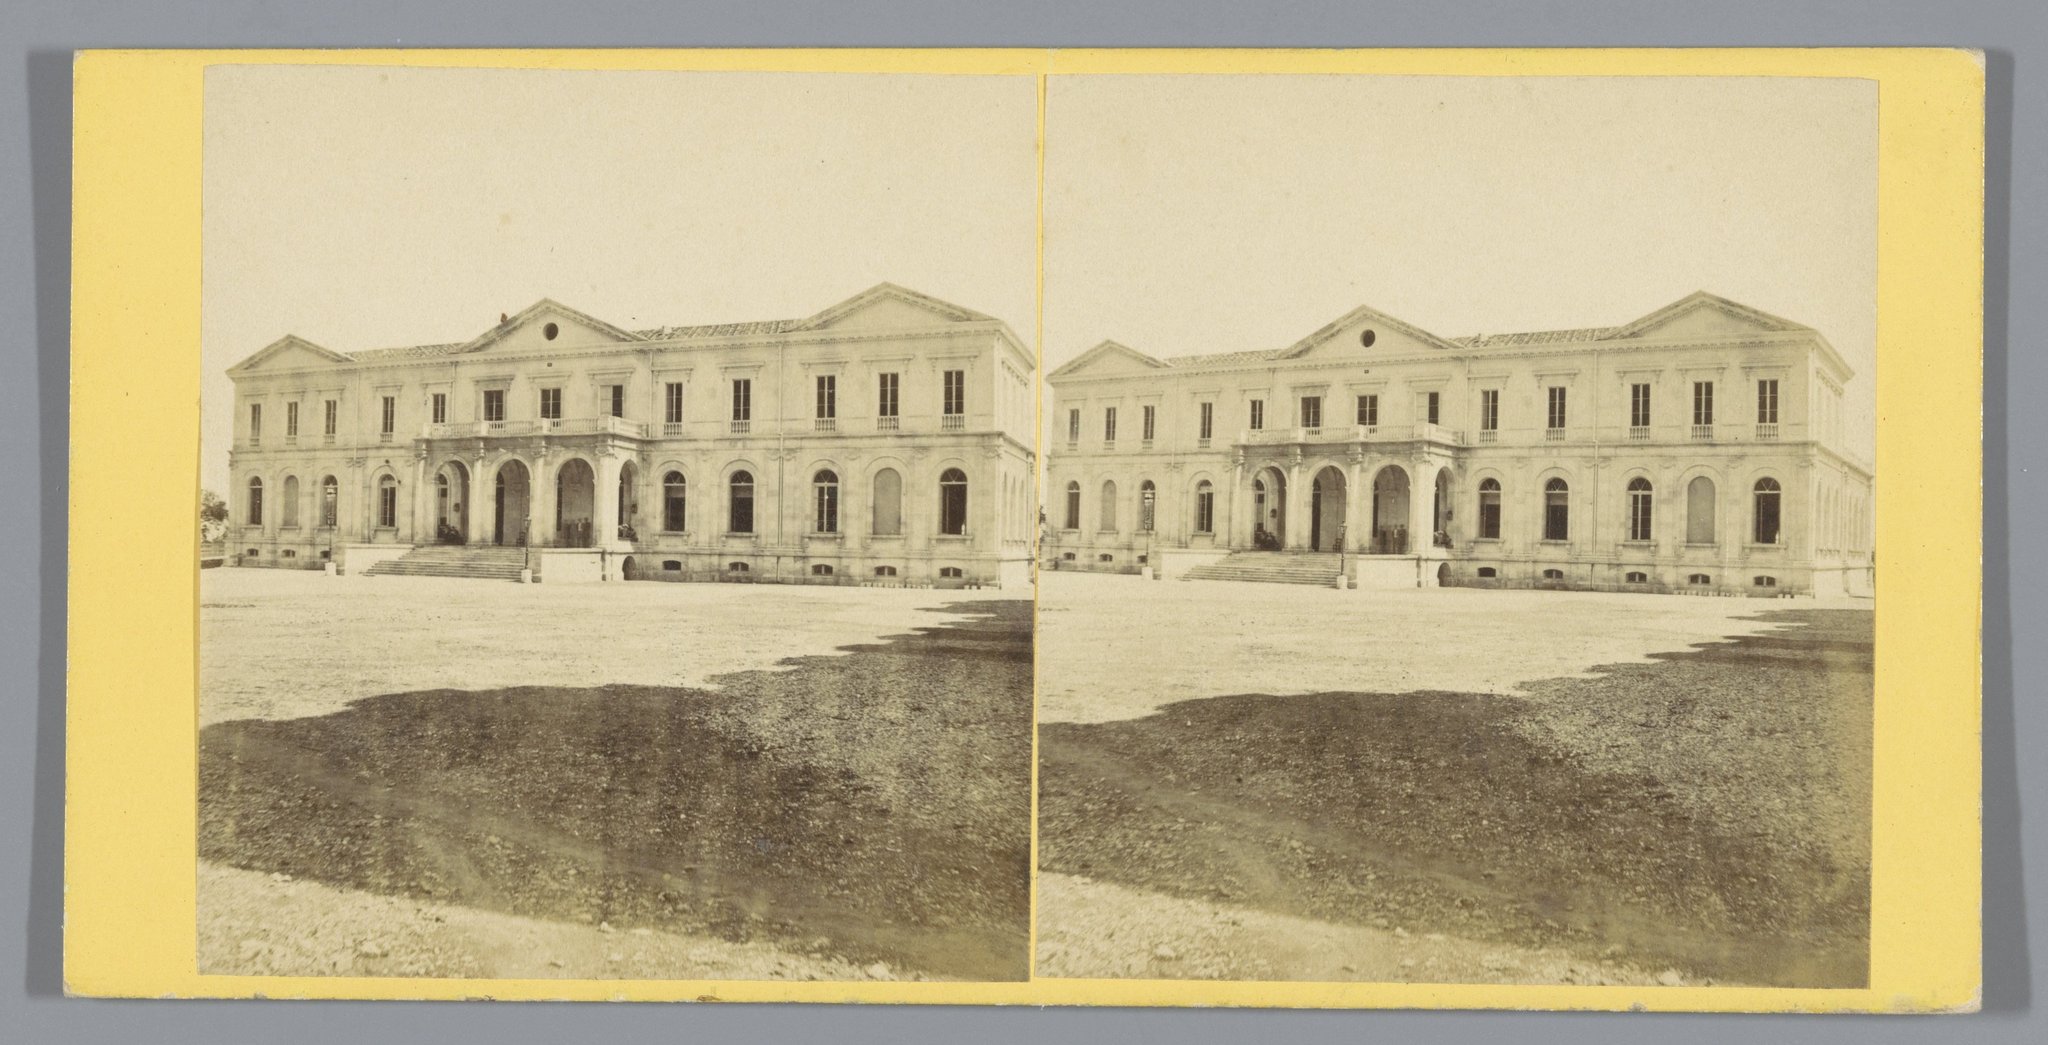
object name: stereograph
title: Casino à Monaco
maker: Anonymous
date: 1850-1880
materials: cardboard, photographic support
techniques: albumen print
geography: monaco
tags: casino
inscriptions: number: ‘553.’